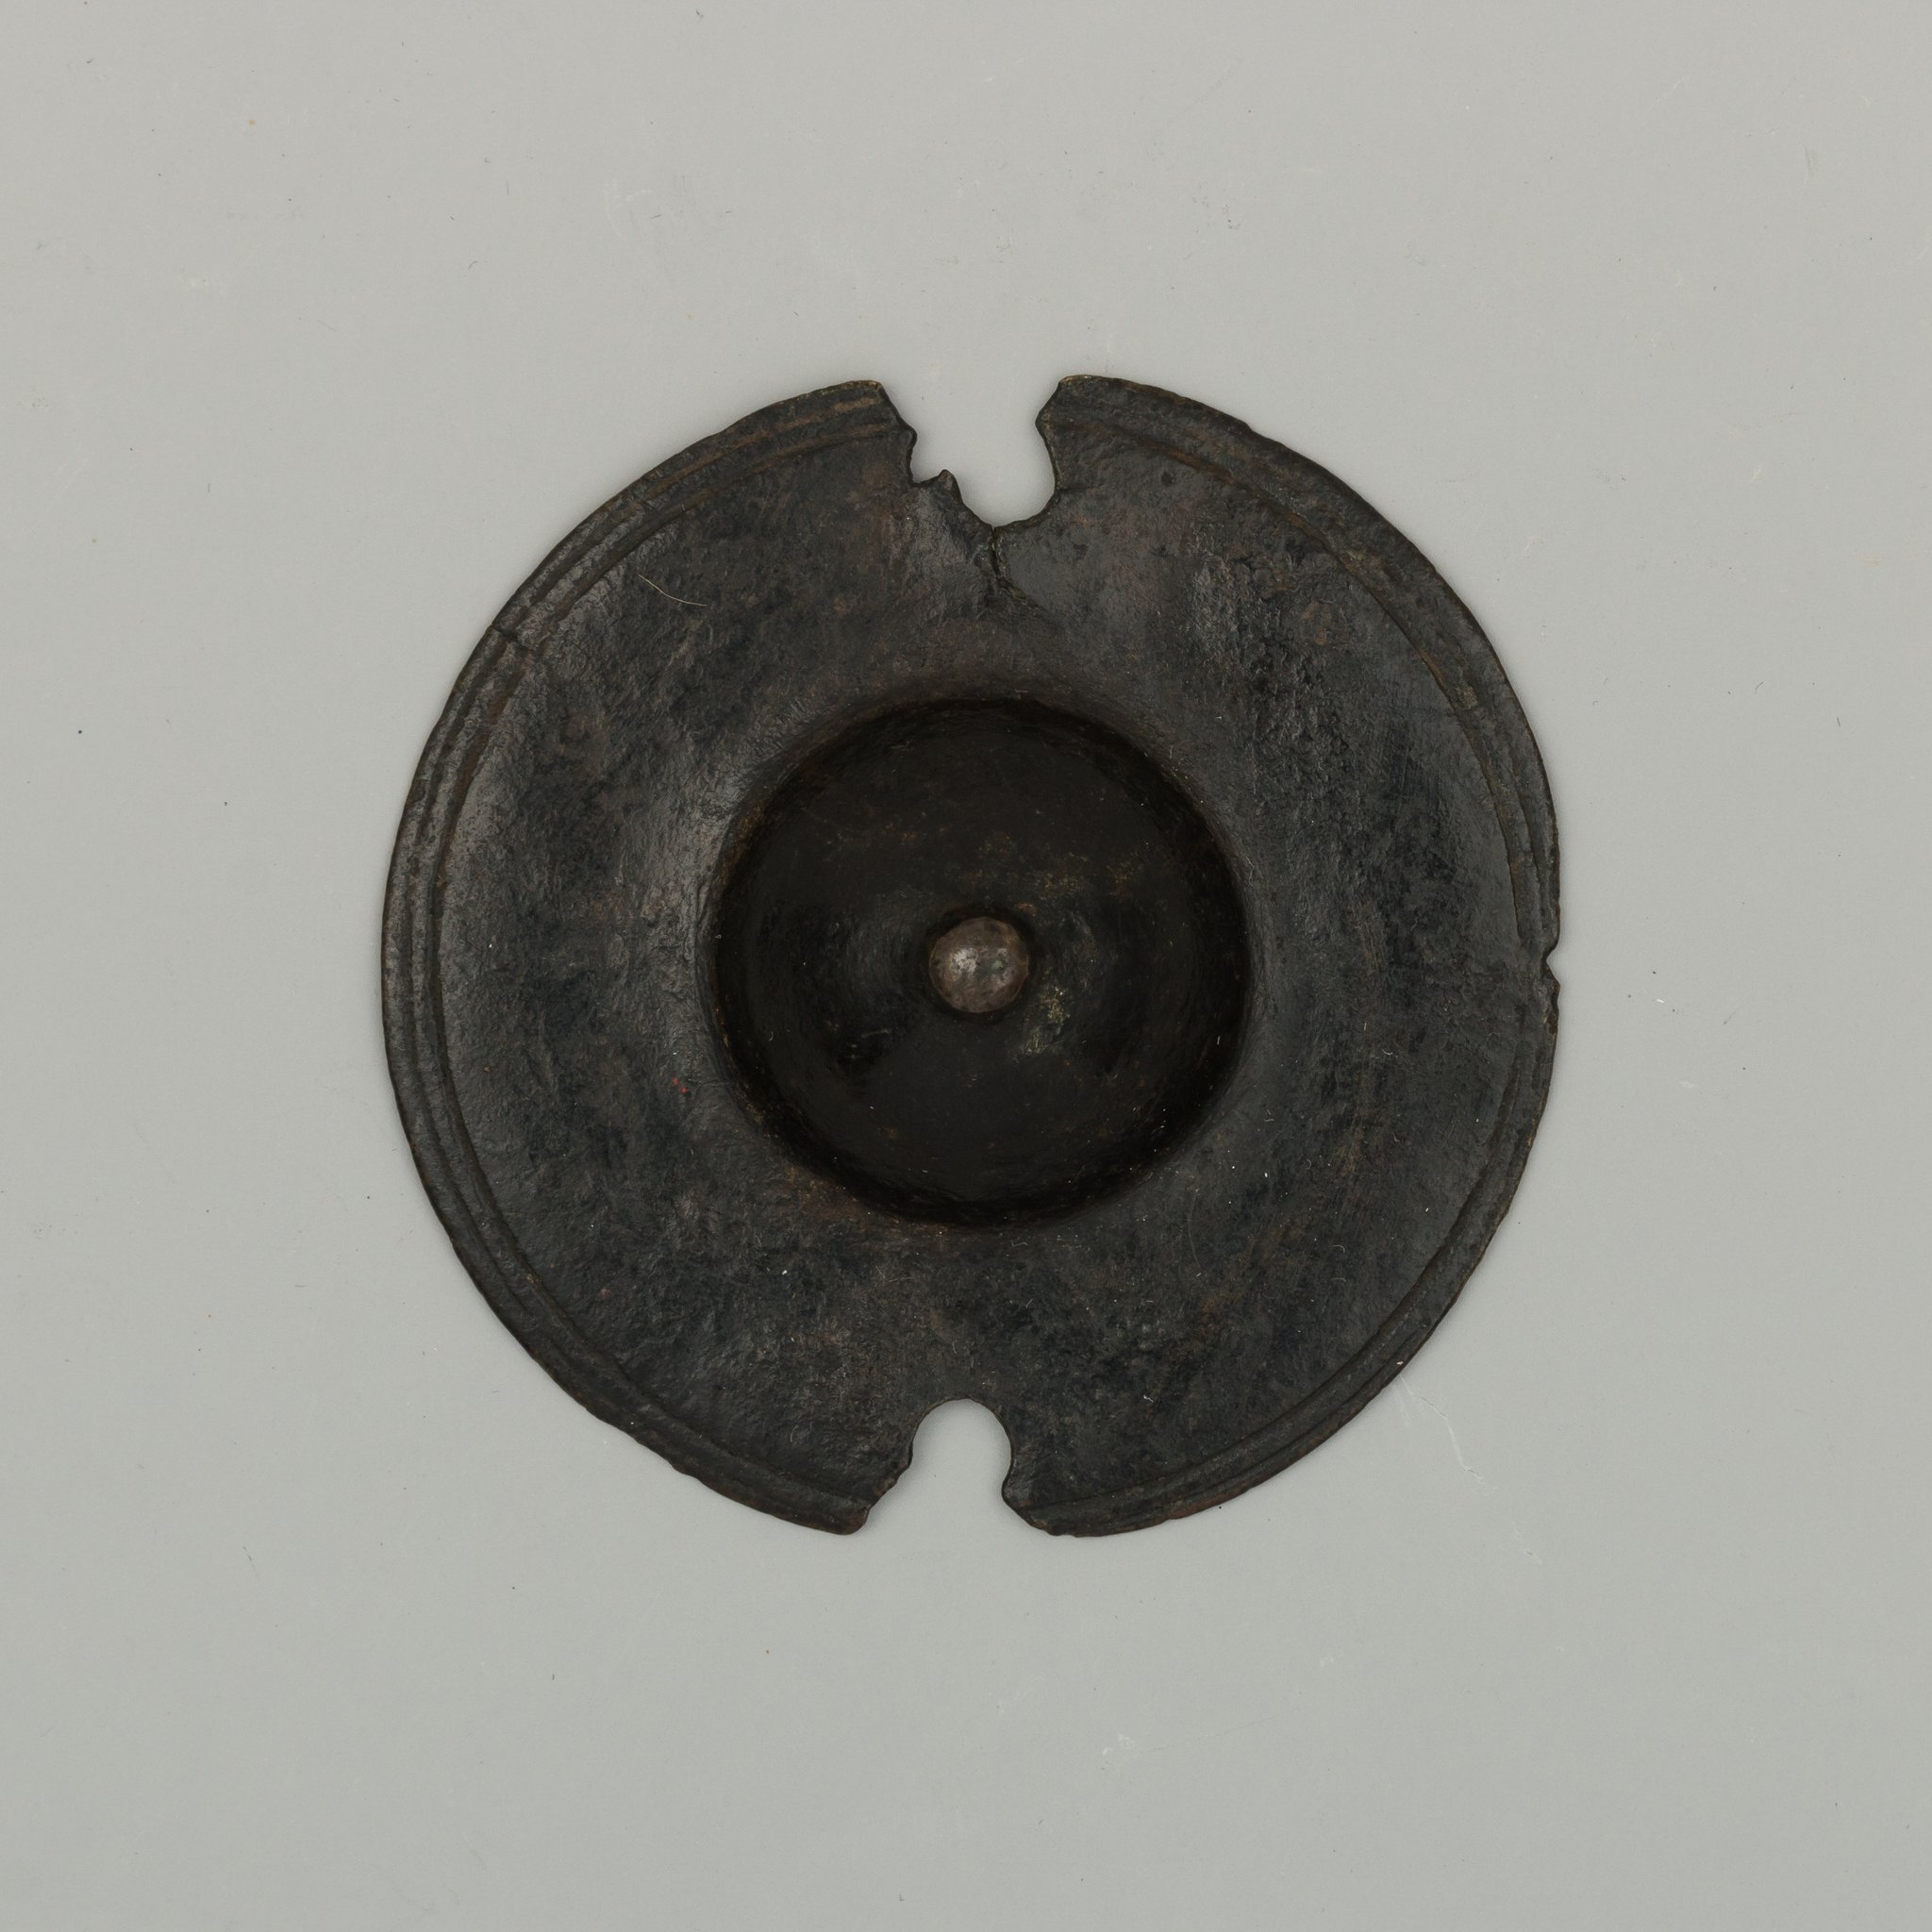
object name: bit bos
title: Bit Boss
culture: french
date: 1501-1550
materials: copper alloy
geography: france